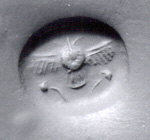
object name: stamp seal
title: Stamp seal (scaraboid) with divine symbol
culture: phoenician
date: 900-601 BCE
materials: limestone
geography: levant or syria